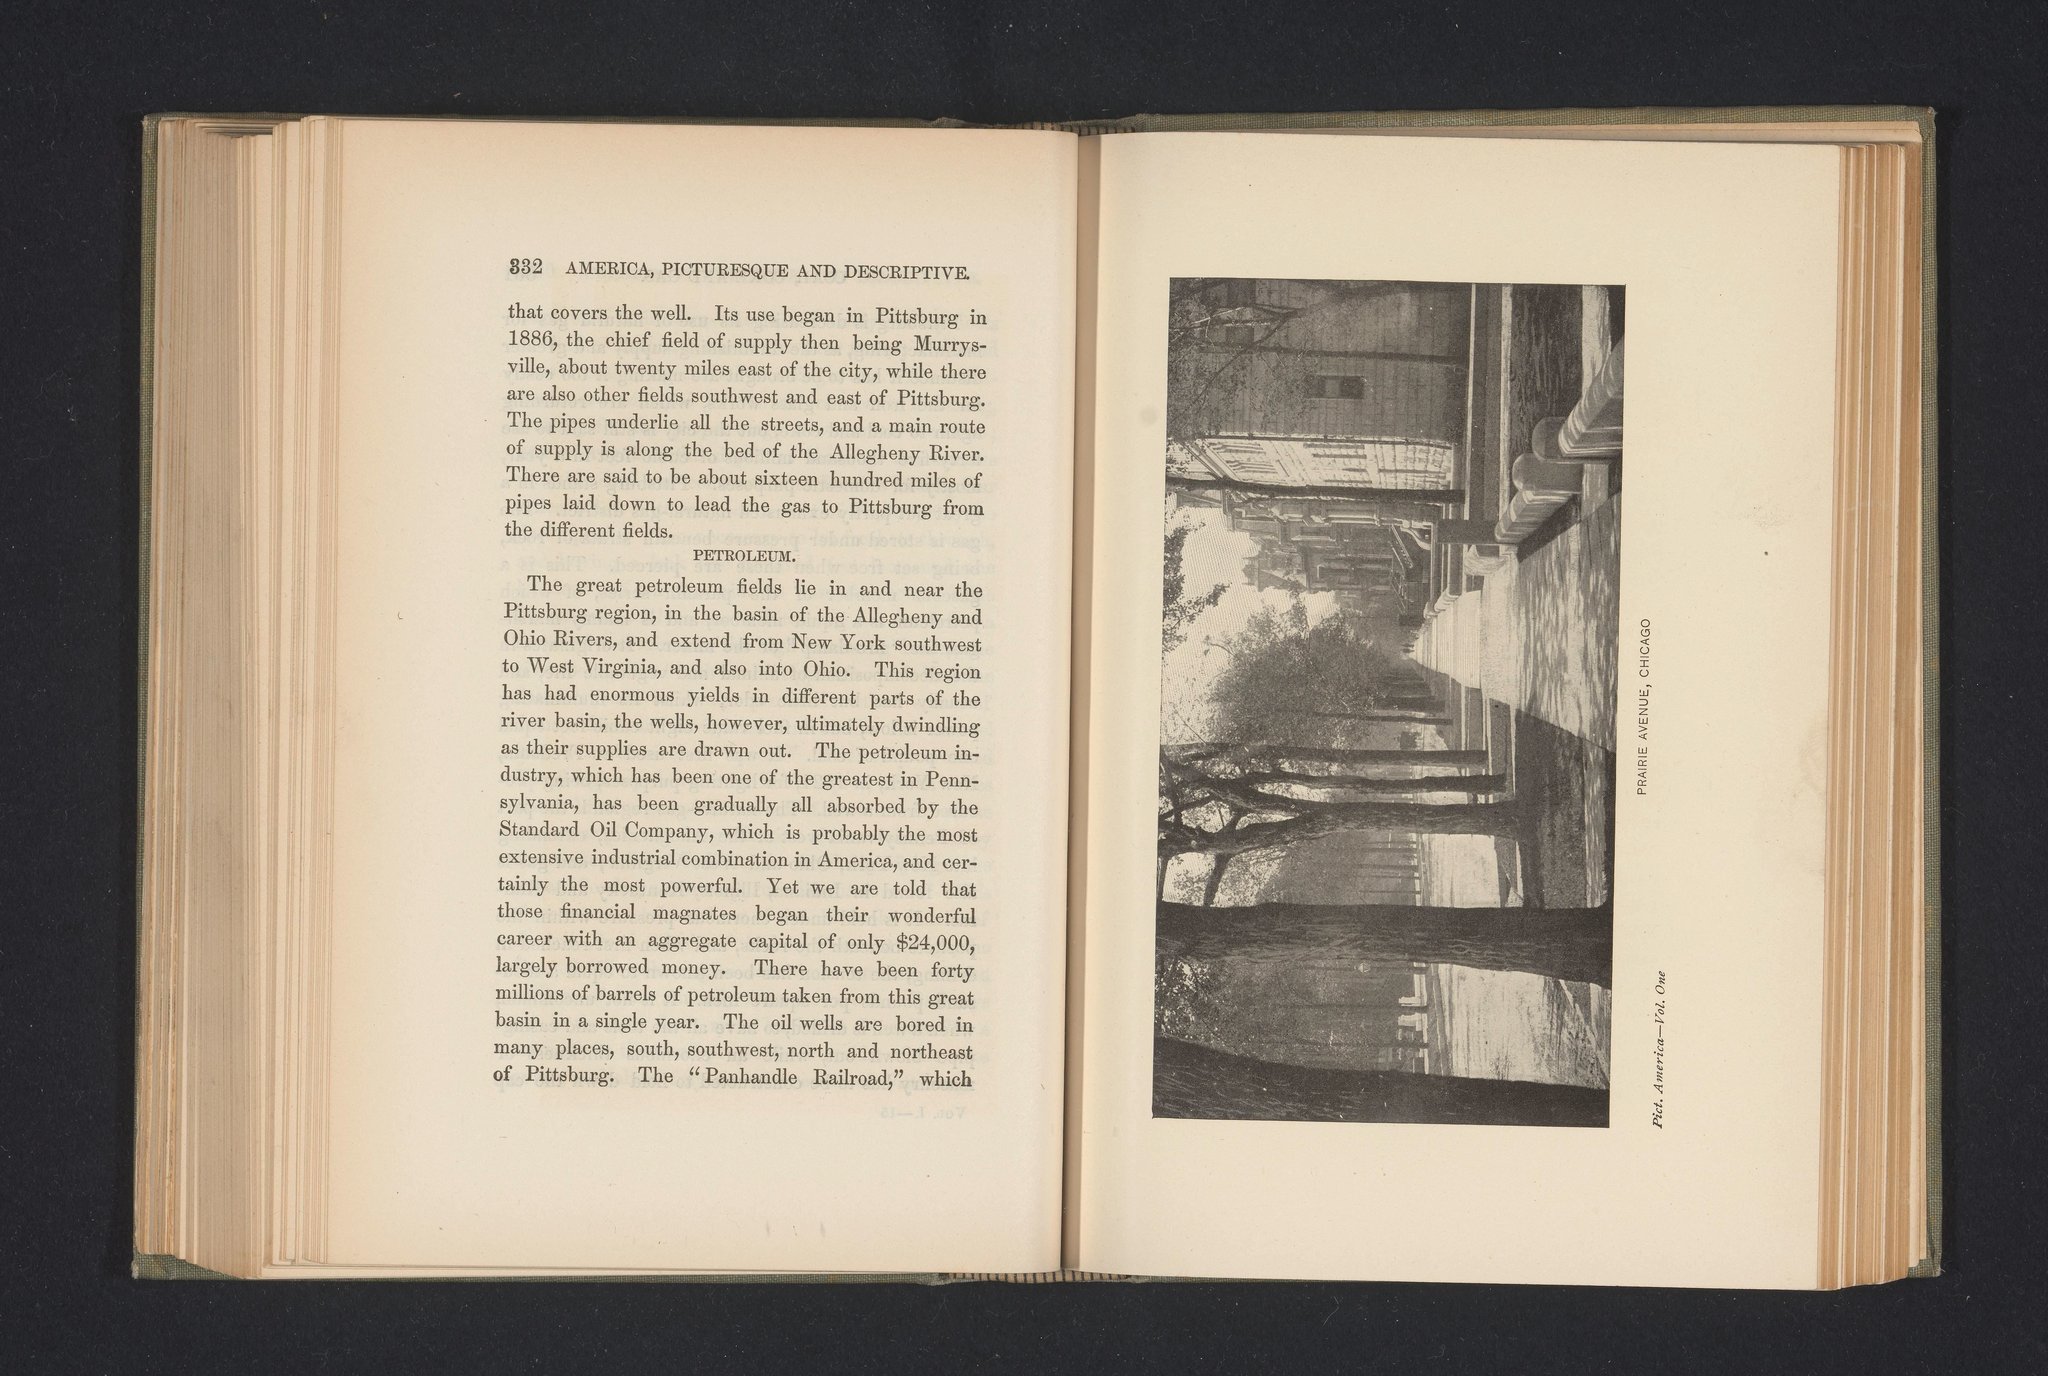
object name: page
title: Prairie Avenue, Chicago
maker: Anonymous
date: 1890-1900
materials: paper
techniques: autotype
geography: prairie avenue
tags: avenue, boulevard in village